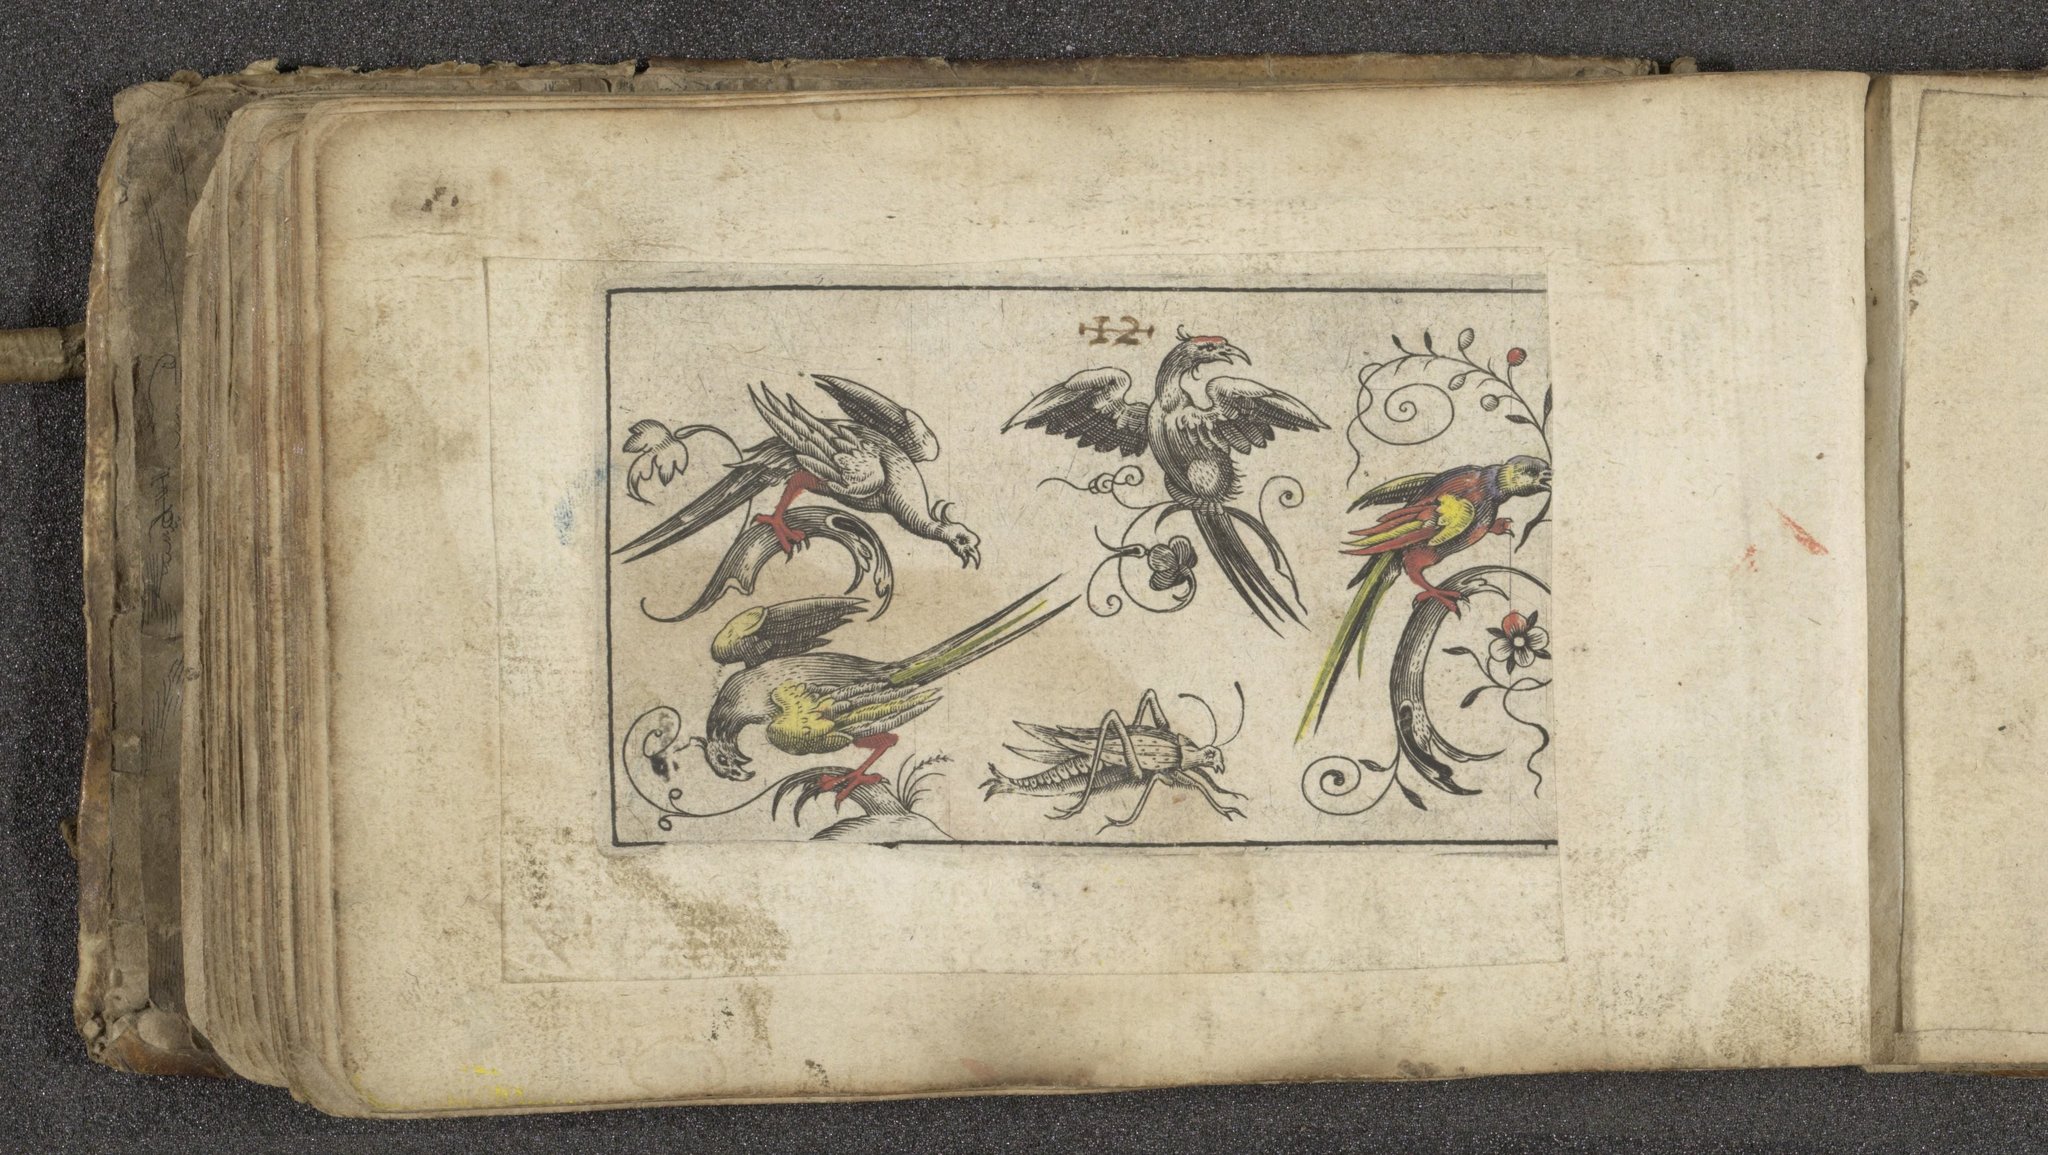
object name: album leaf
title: Vogels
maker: Anonymous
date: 1601-1650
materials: paper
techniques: colour, engraving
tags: birds, insects: grass-hopper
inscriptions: inscription: ‘62’, inscription: ‘12’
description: Kopie in spiegelbeeld van een prent in de serie vogels van Adriaen Muntinck.